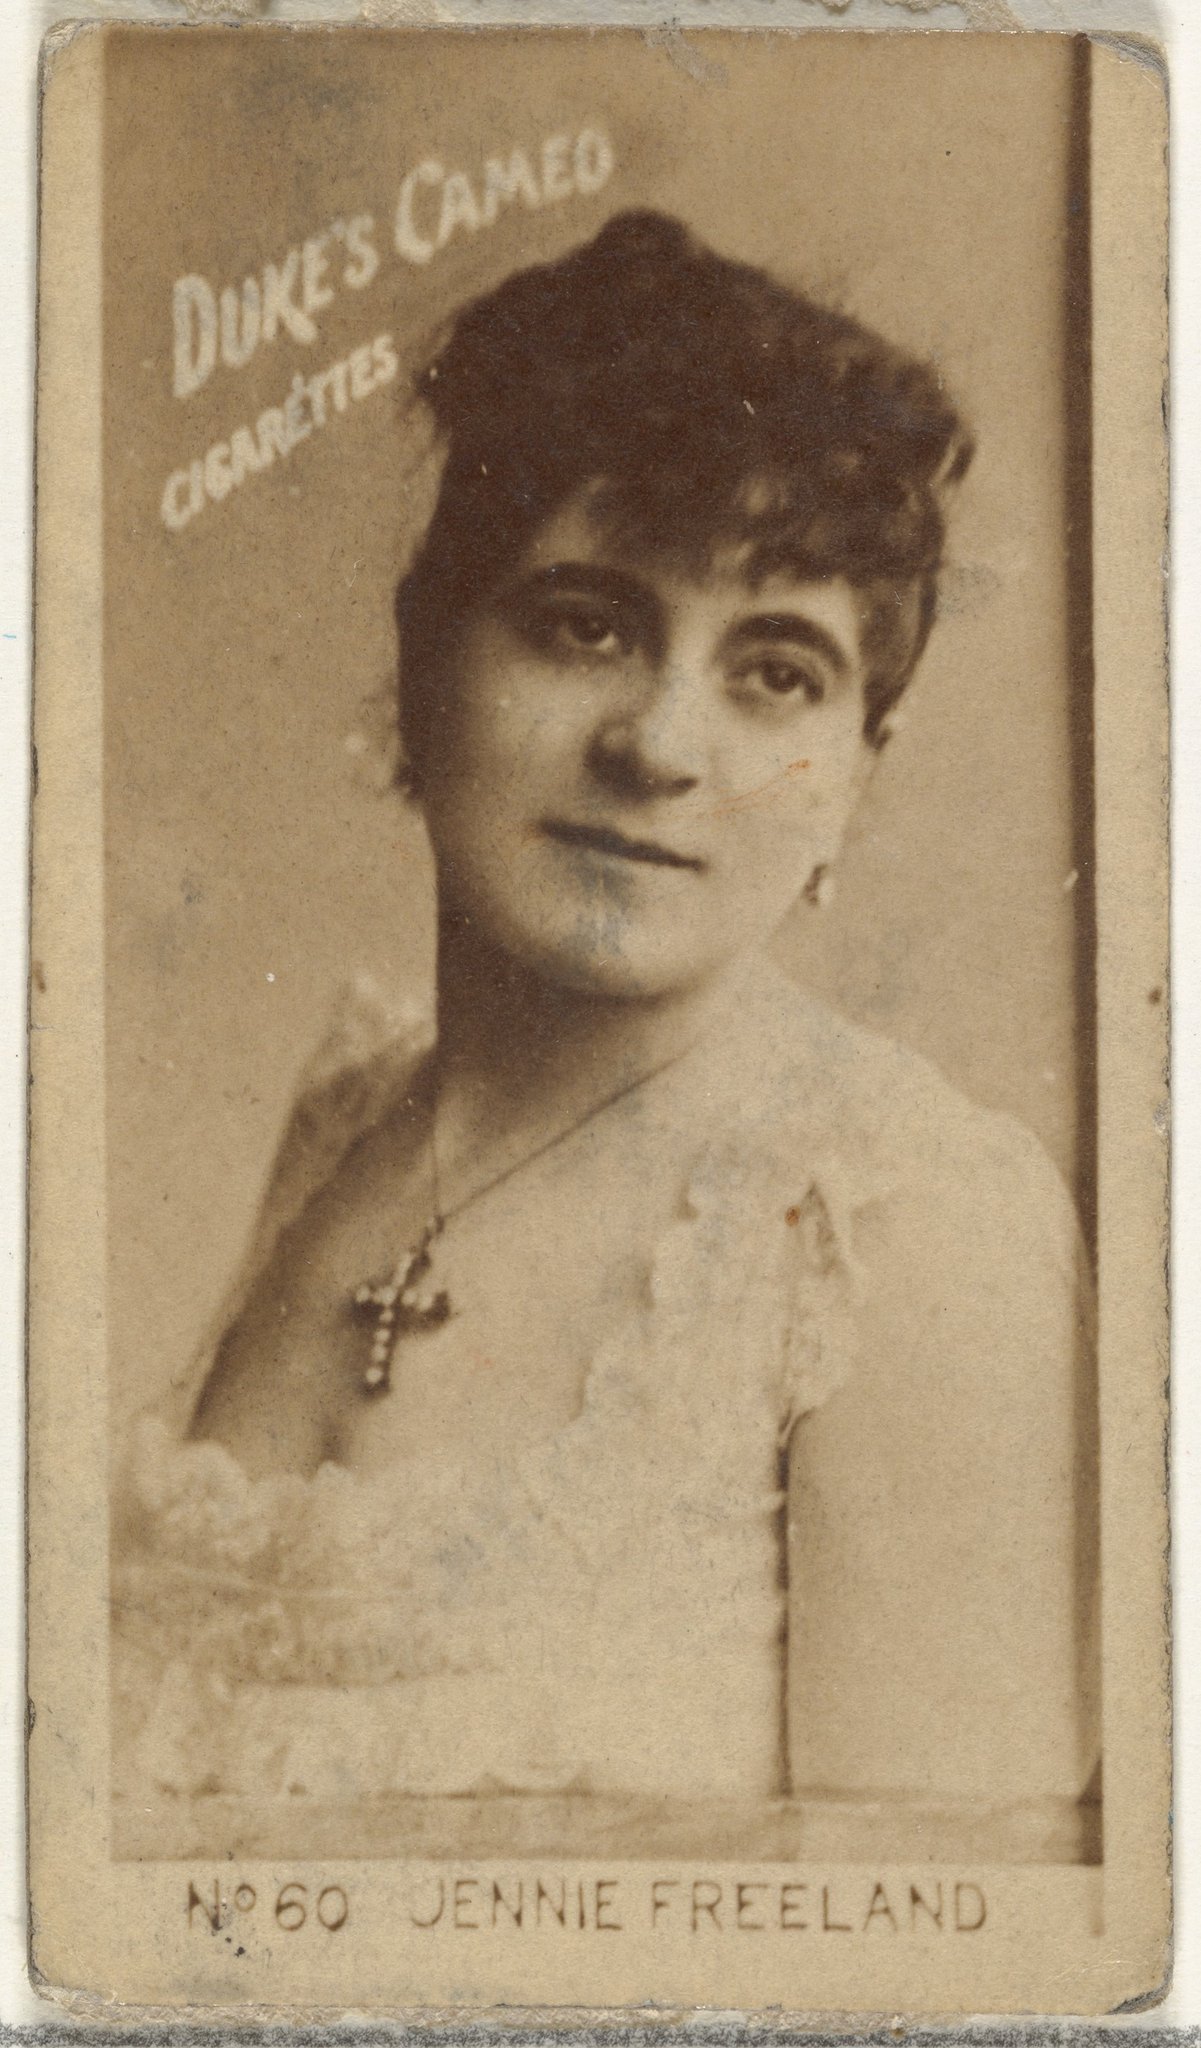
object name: photograph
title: Card Number 60, Jennie Freeland, from the Actors and Actresses series (N145-4) issued by Duke Sons & Co. to promote Cameo Cigarettes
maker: w. duke, sons & co.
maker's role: publisher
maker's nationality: american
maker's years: 1870-1920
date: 1880-1889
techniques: albumen silver print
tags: portraits,women,actresses